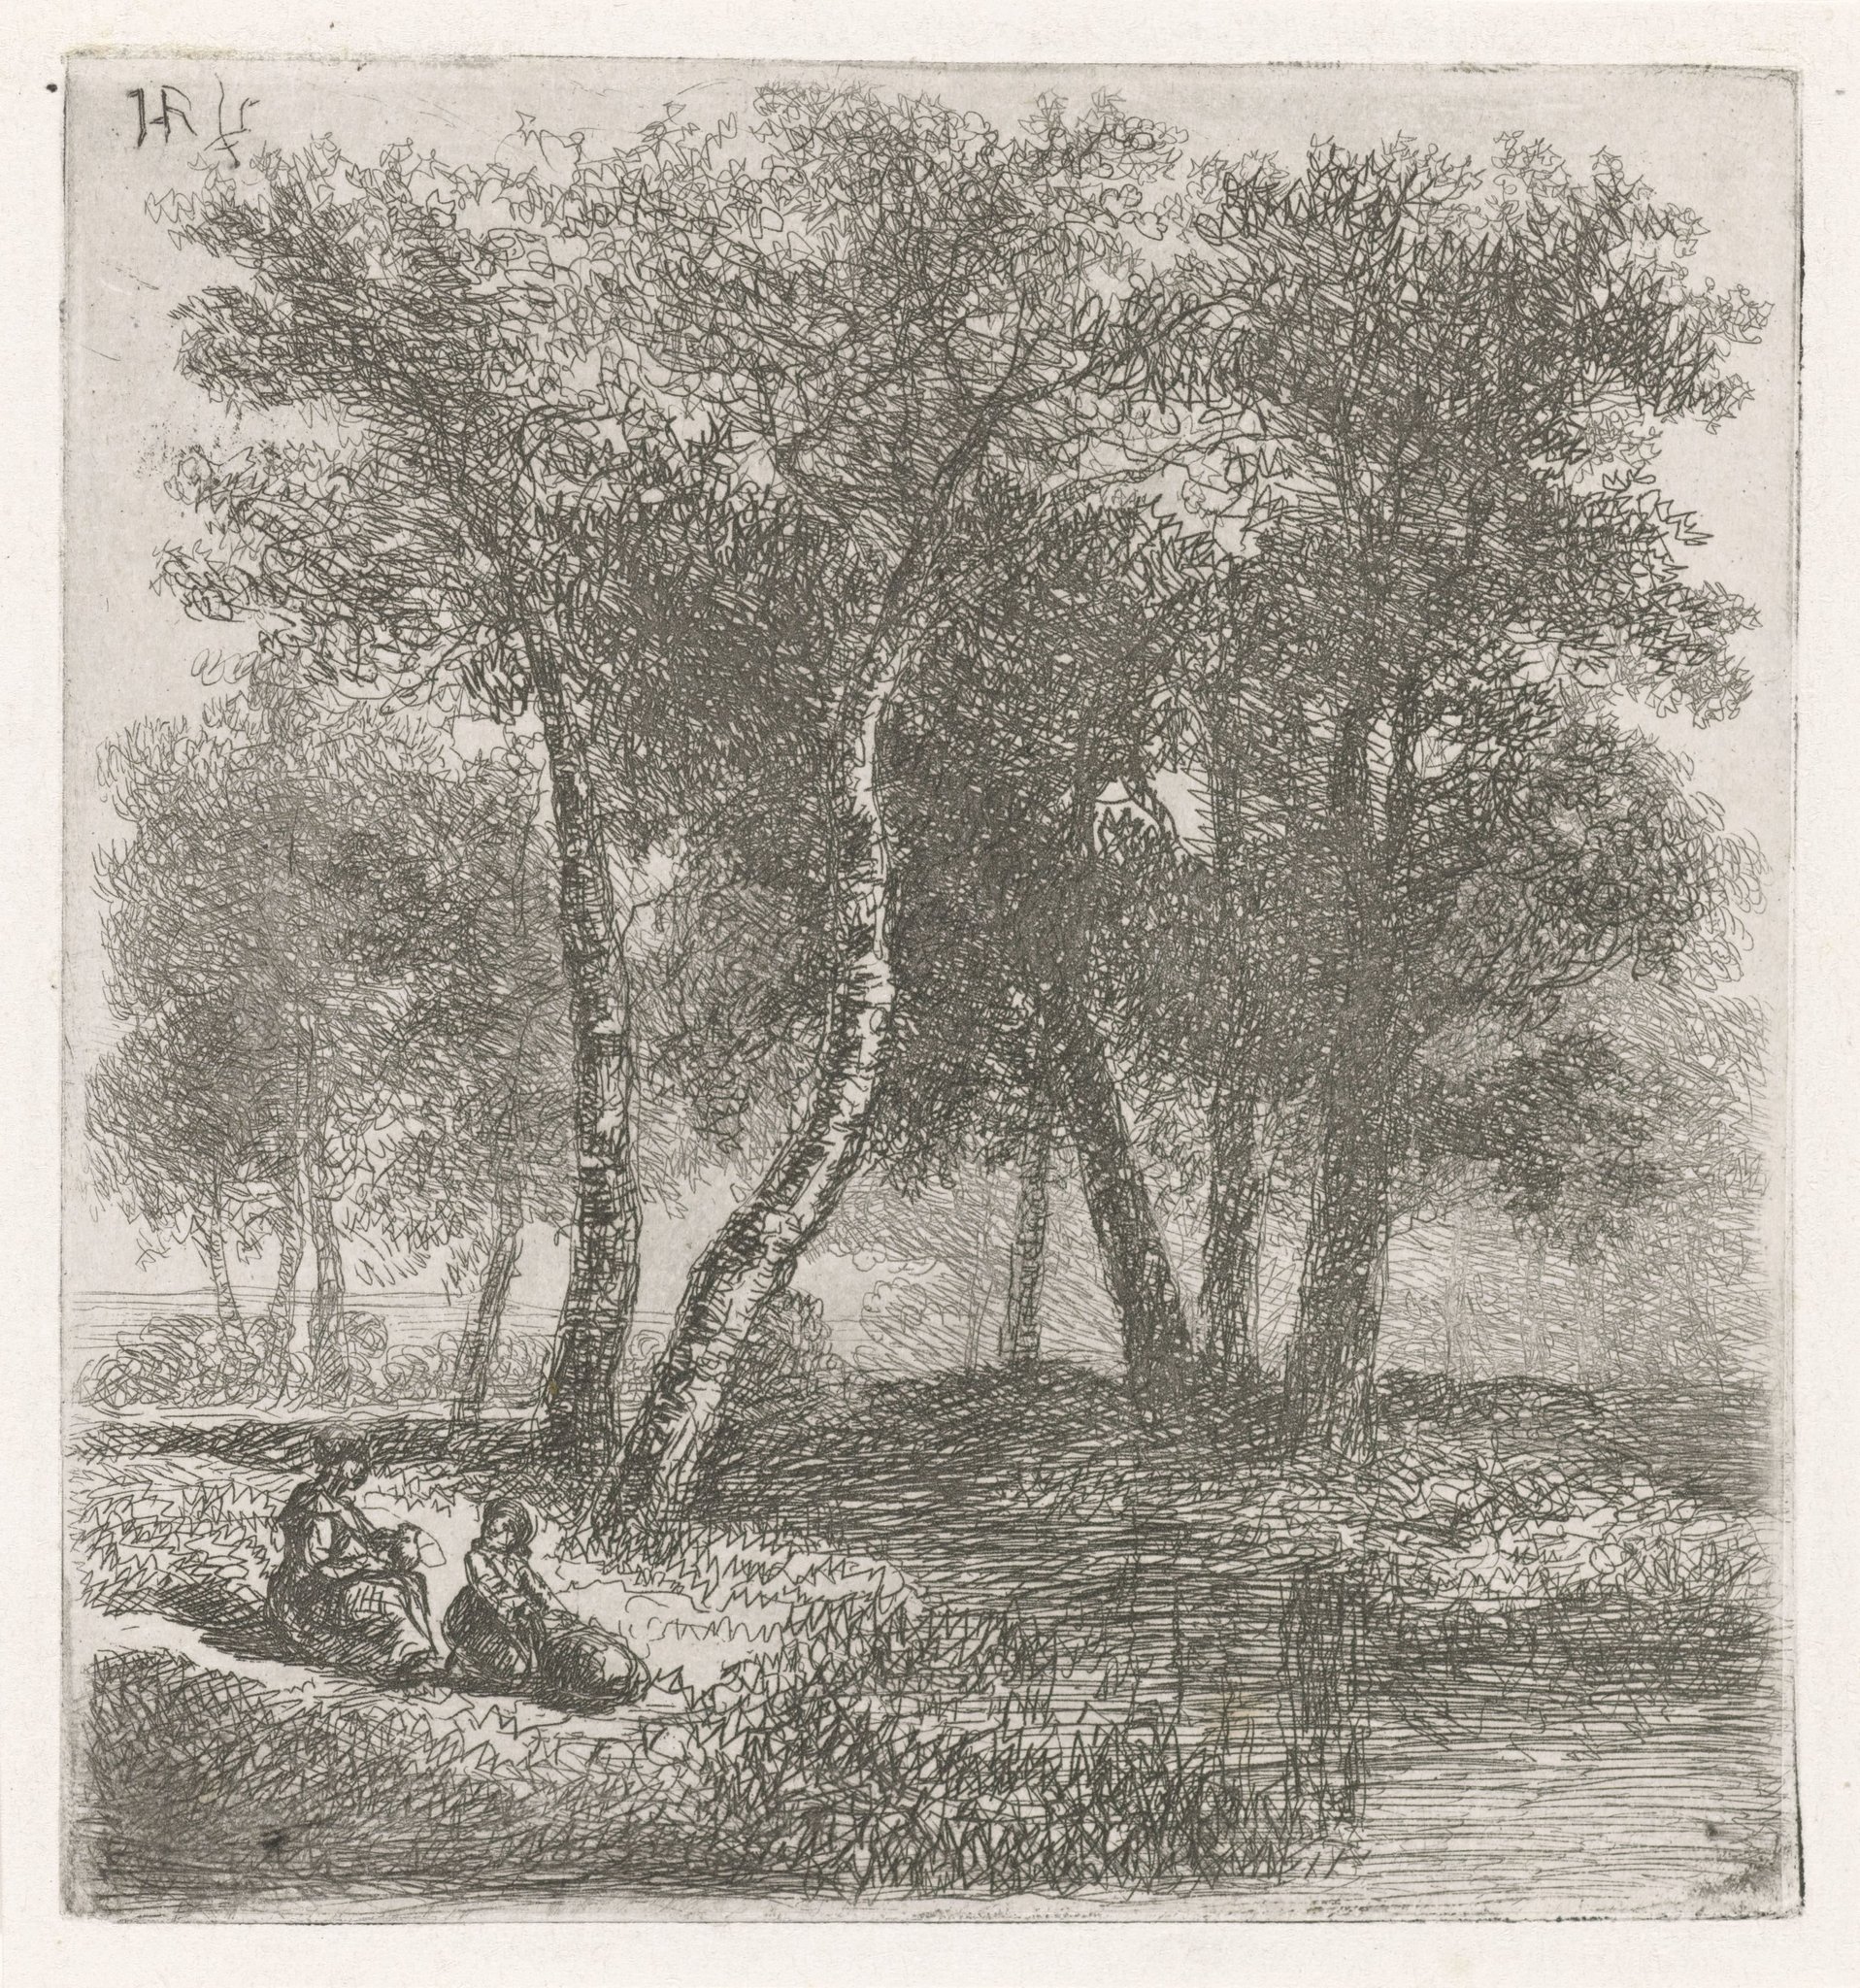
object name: print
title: Moeder en kind aan de waterkant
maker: hermanus jan hendrik van rijkelijkhuysen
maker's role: painter, print maker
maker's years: 1813-1883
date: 1823-1883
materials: paper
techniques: drypoint, etching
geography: utrecht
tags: swamp, inland marsh, fens (+ landscape with figures, staffage), mother and baby or young child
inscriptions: collector's mark: Lugt 2228, collector's mark: Lugt 1485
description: In een bos zitten een moeder en haar kind aan de rand van een ven.